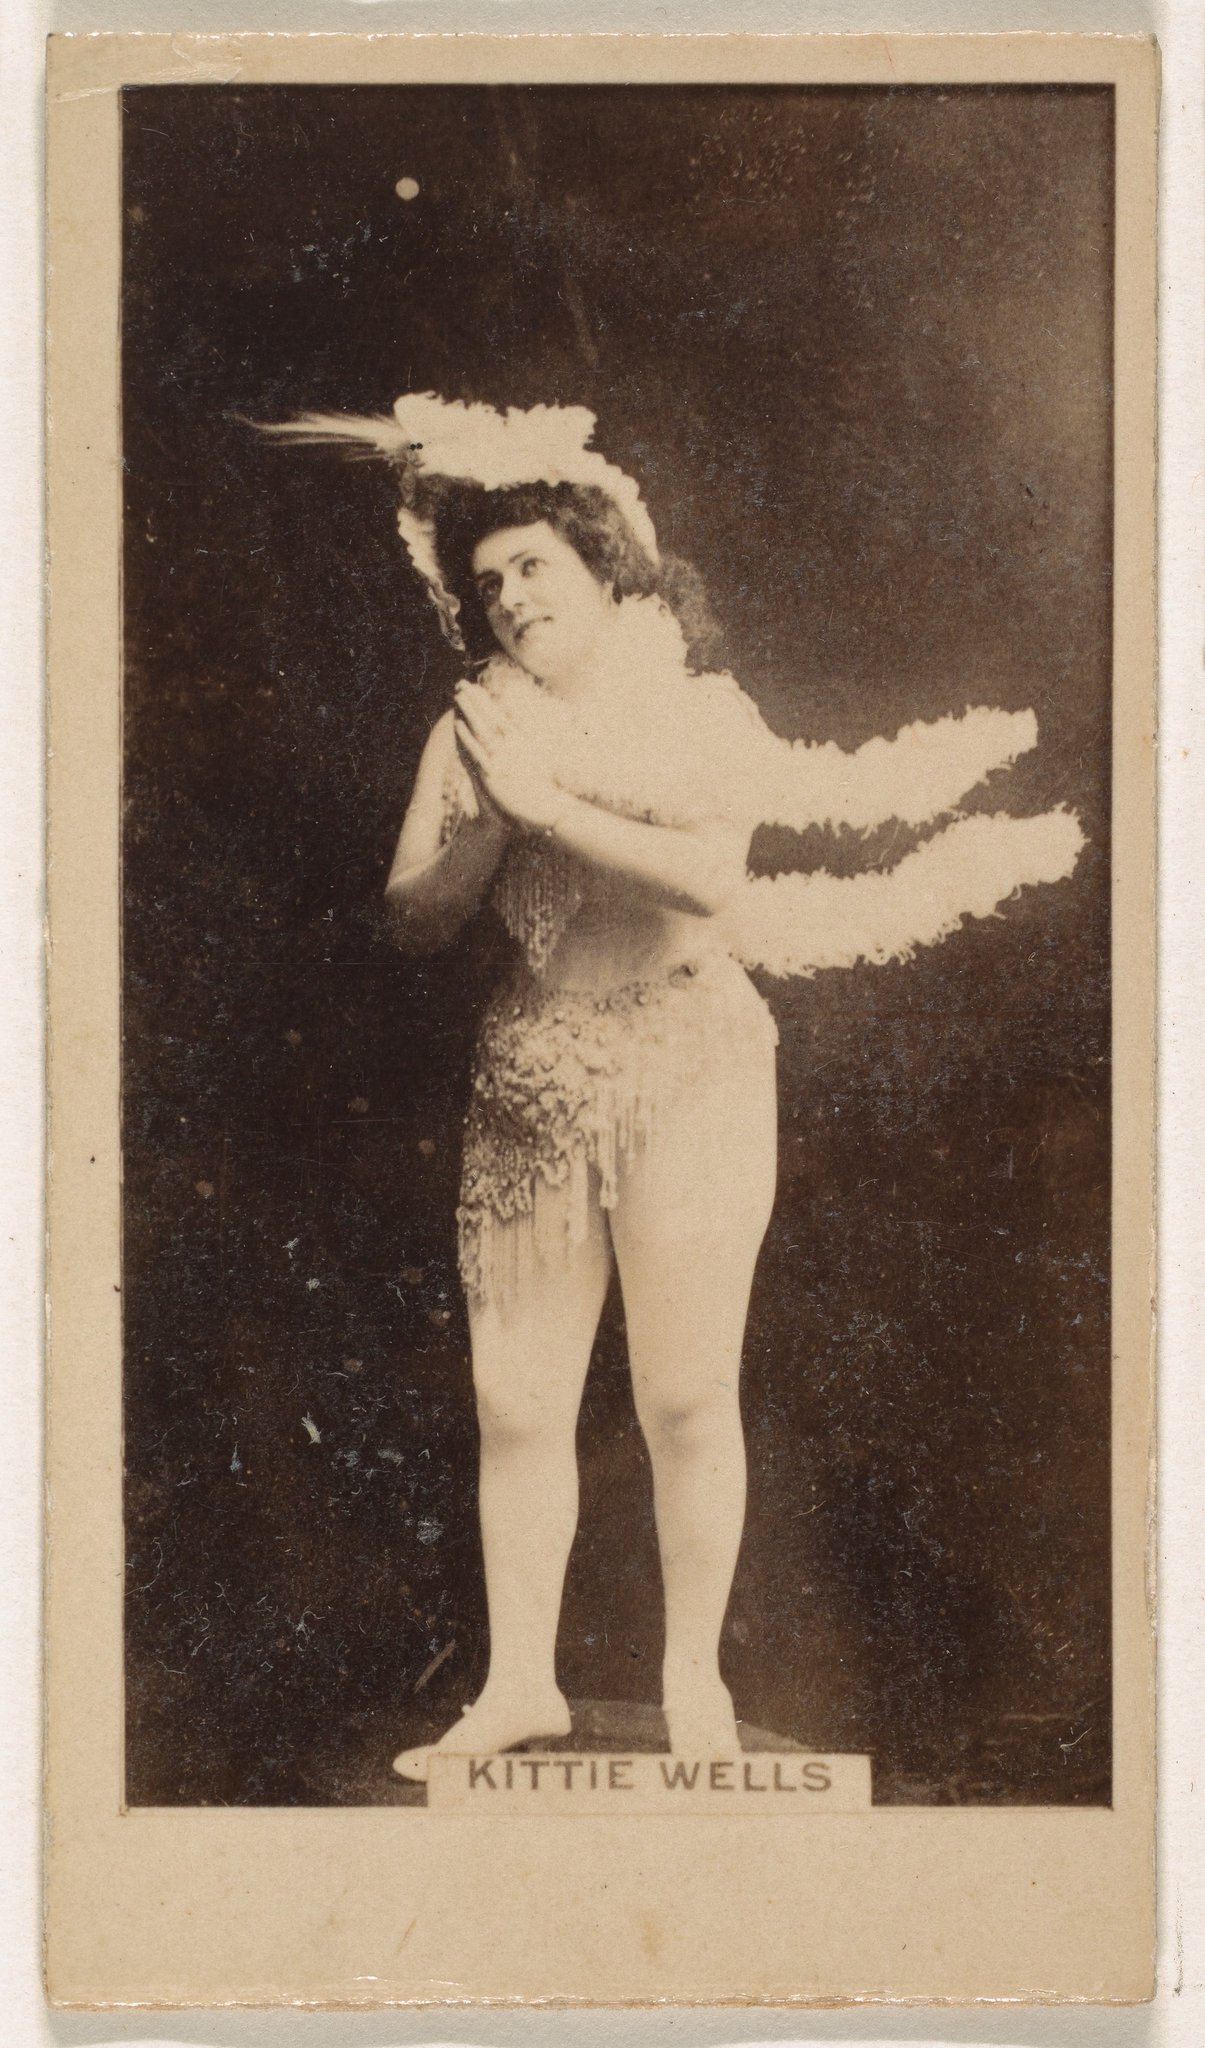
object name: photograph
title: Kittie Wells, from the Actresses series (N245) issued by Kinney Brothers to promote Sweet Caporal Cigarettes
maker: kinney brothers tobacco company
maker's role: publisher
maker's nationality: american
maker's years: 1869-2011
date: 1890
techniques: albumen silver print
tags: portraits,women,actresses